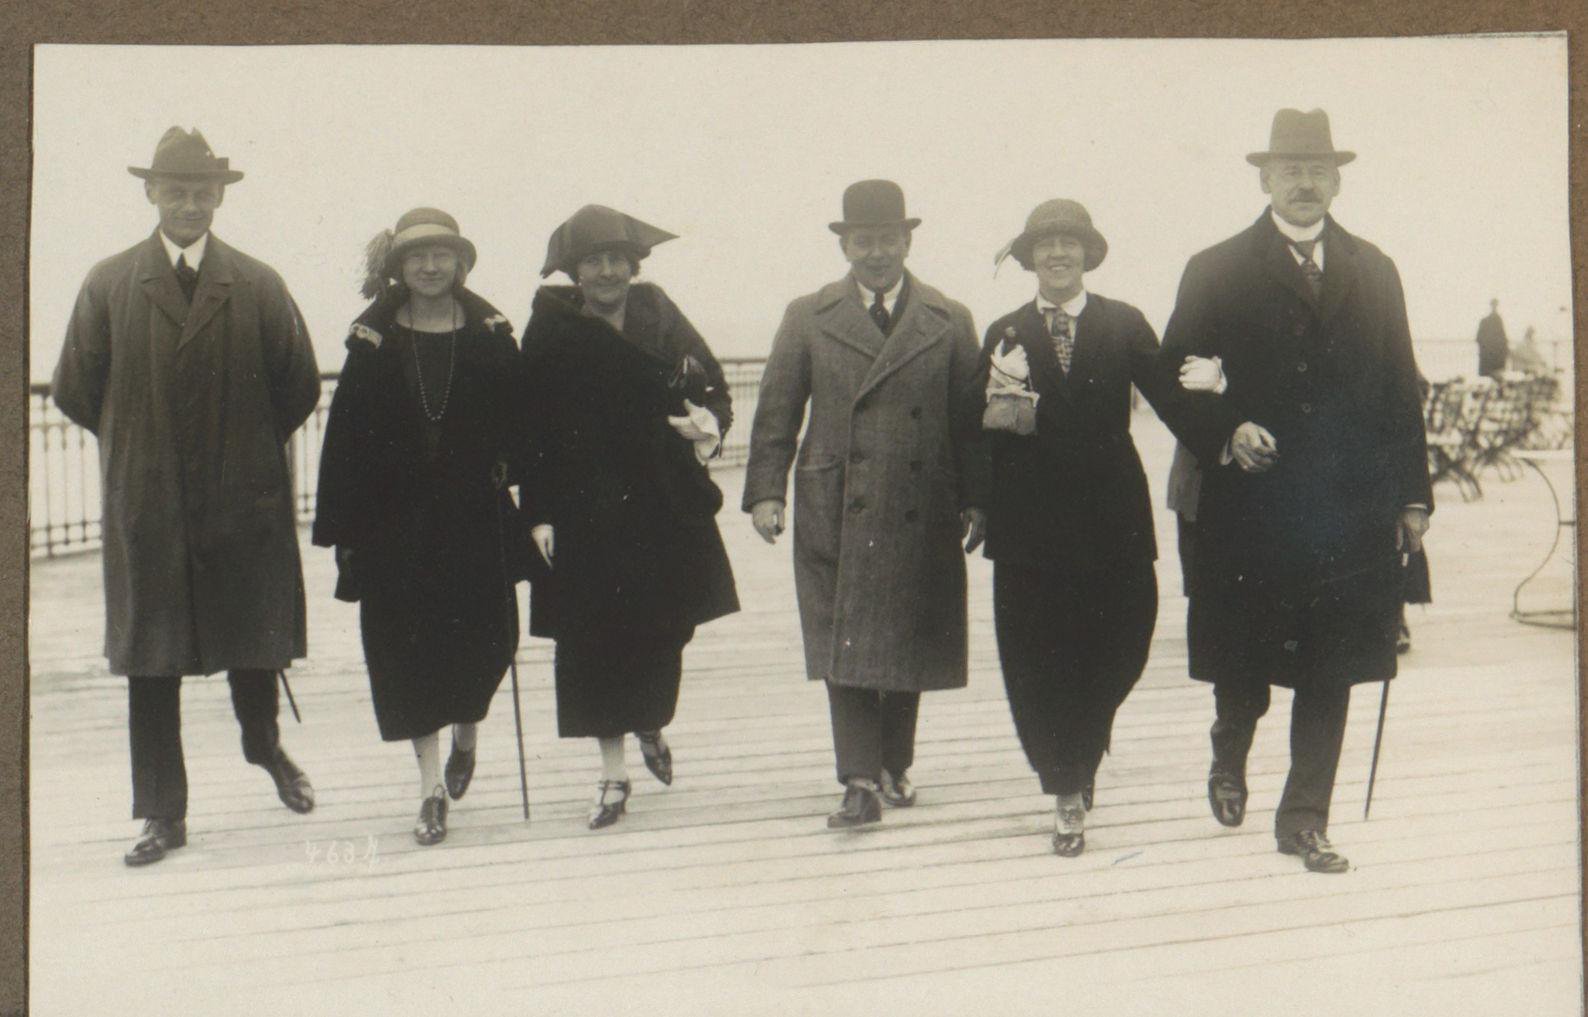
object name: photograph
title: Gezelschap wandelend over (vermoedelijk) de pier van Scheveningen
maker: Anonymous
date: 1904-1924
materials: photographic support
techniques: gelatin silver print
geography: scheveningen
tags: adult woman, strolling, adult man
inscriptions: number: ‘468H’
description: Onderdeel van fotoalbum van een onbekende Nederlandse familie met opnames van Suriname, Europa en Nederlands-Indië.